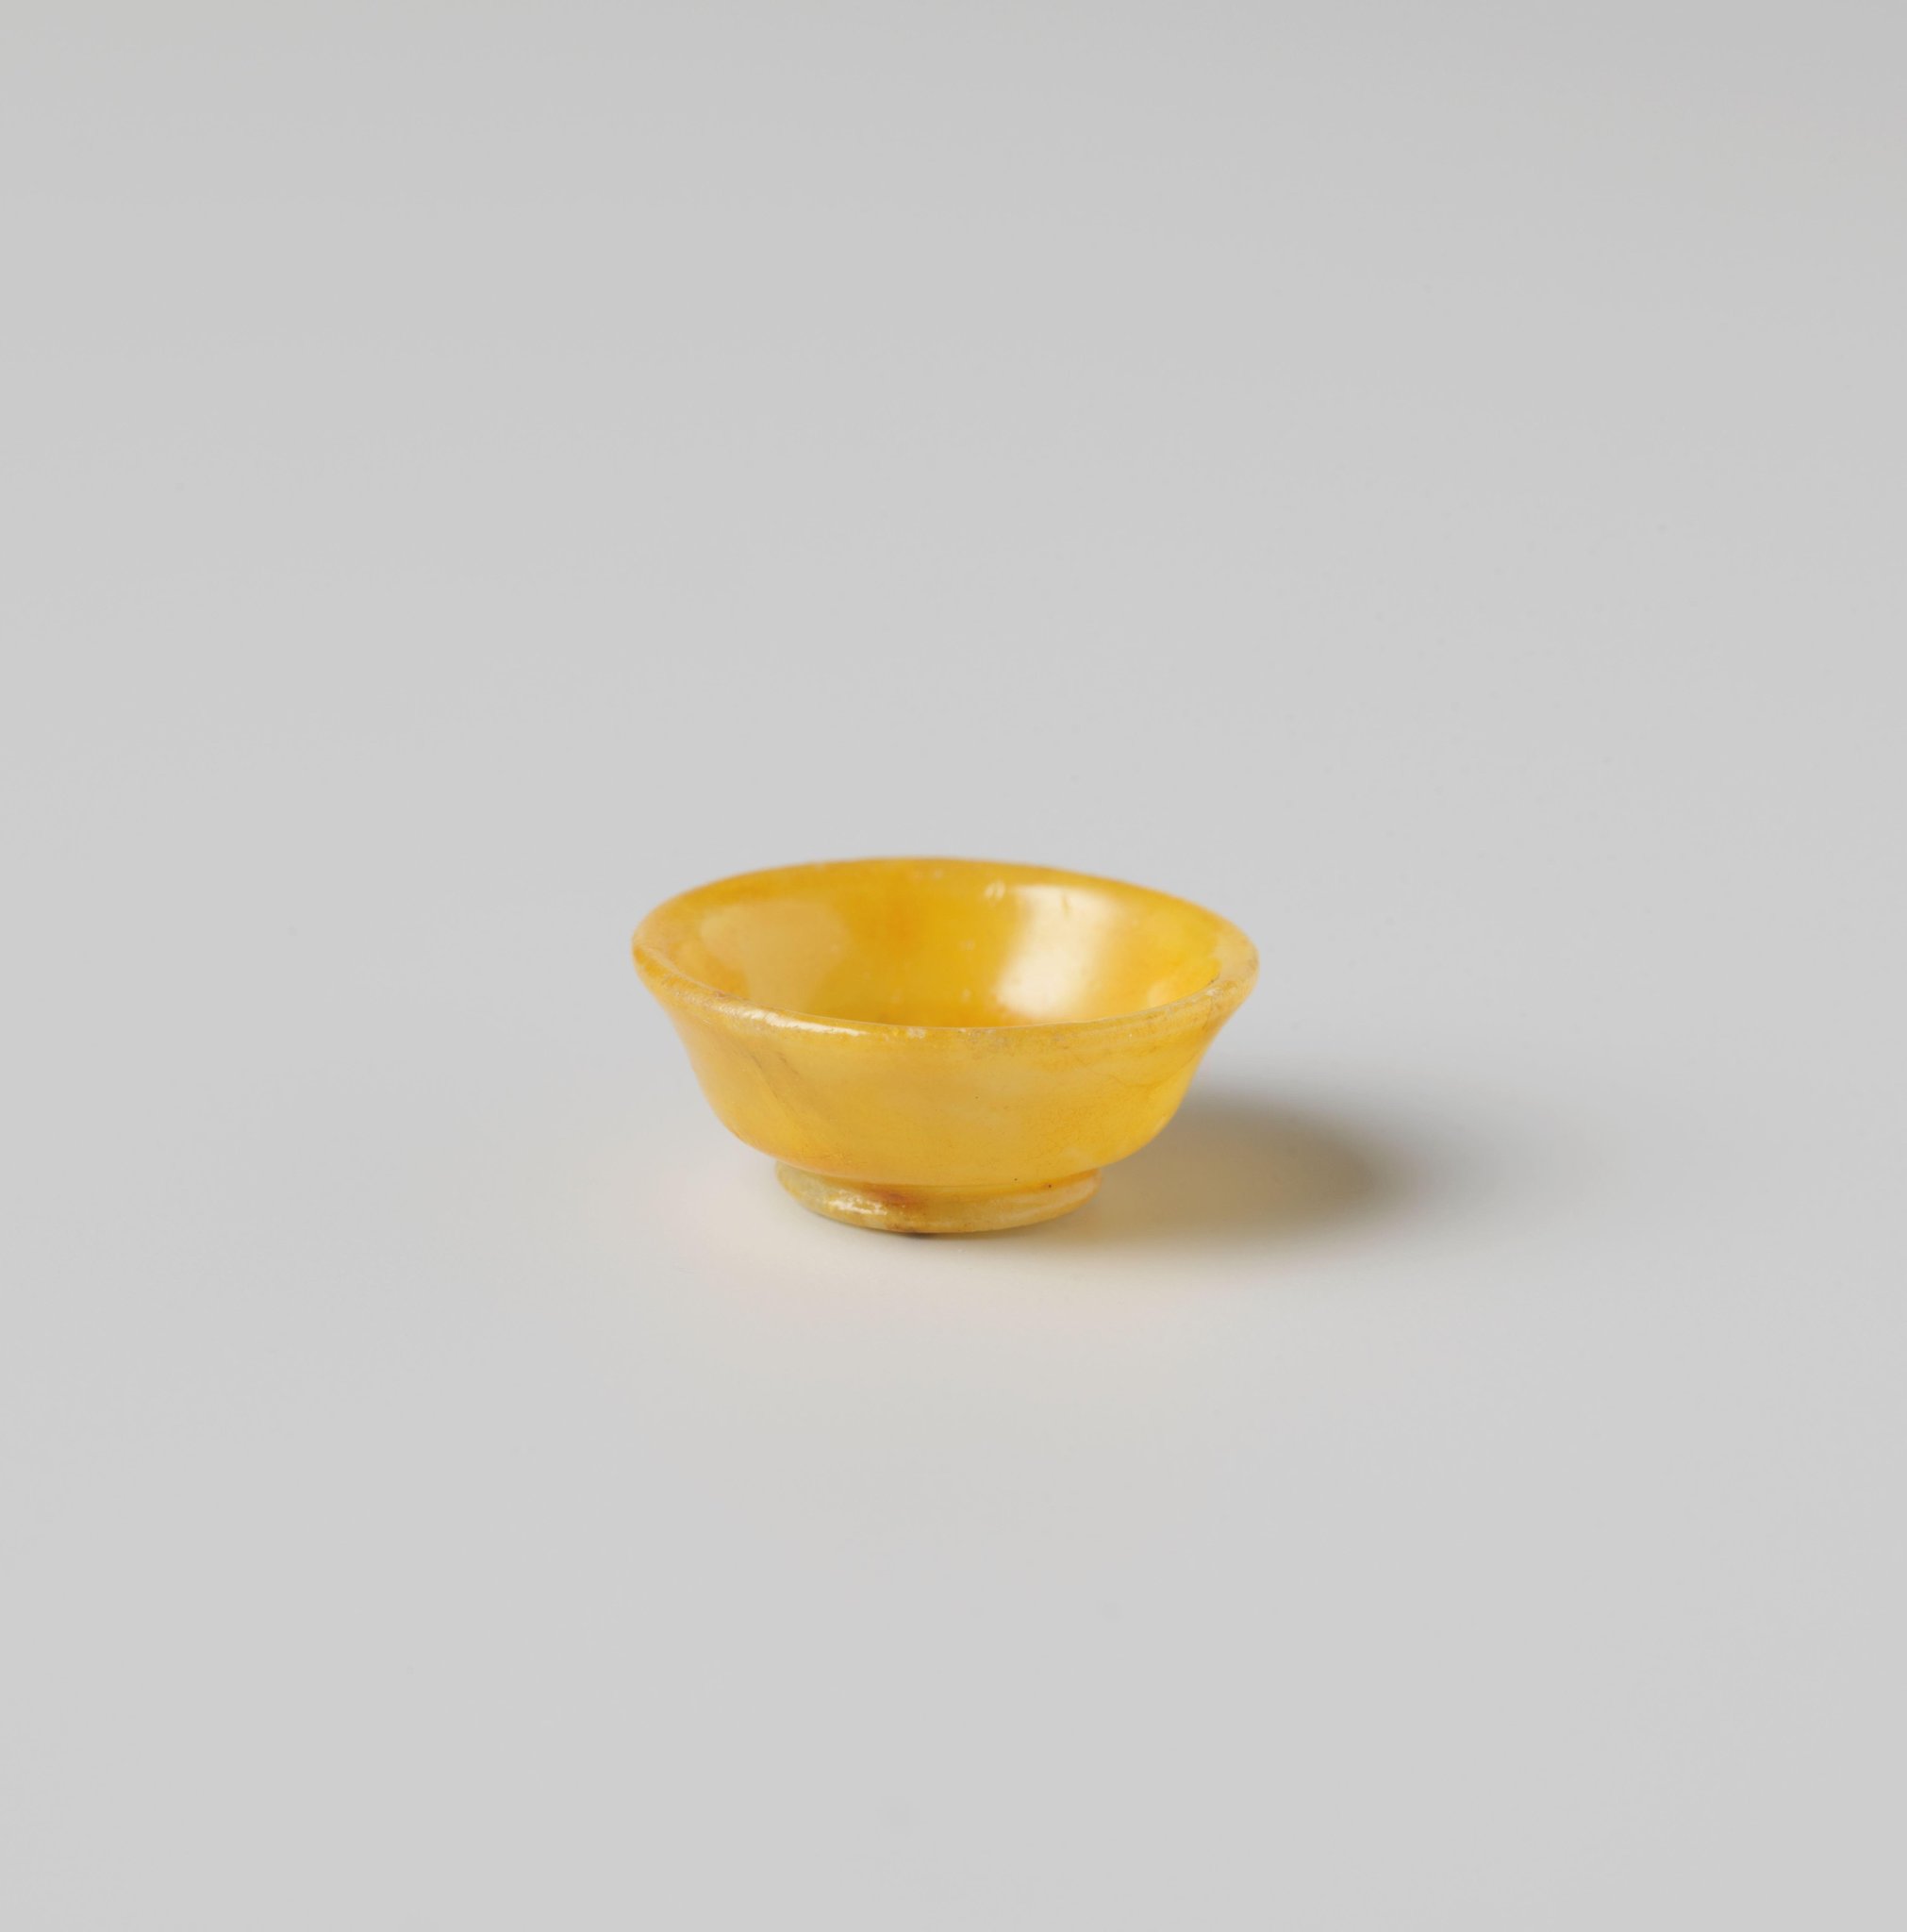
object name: slop bowl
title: Spoelkom, geelgelakt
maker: Anonymous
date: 1750-1800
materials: alabaster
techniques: lacquer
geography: germany